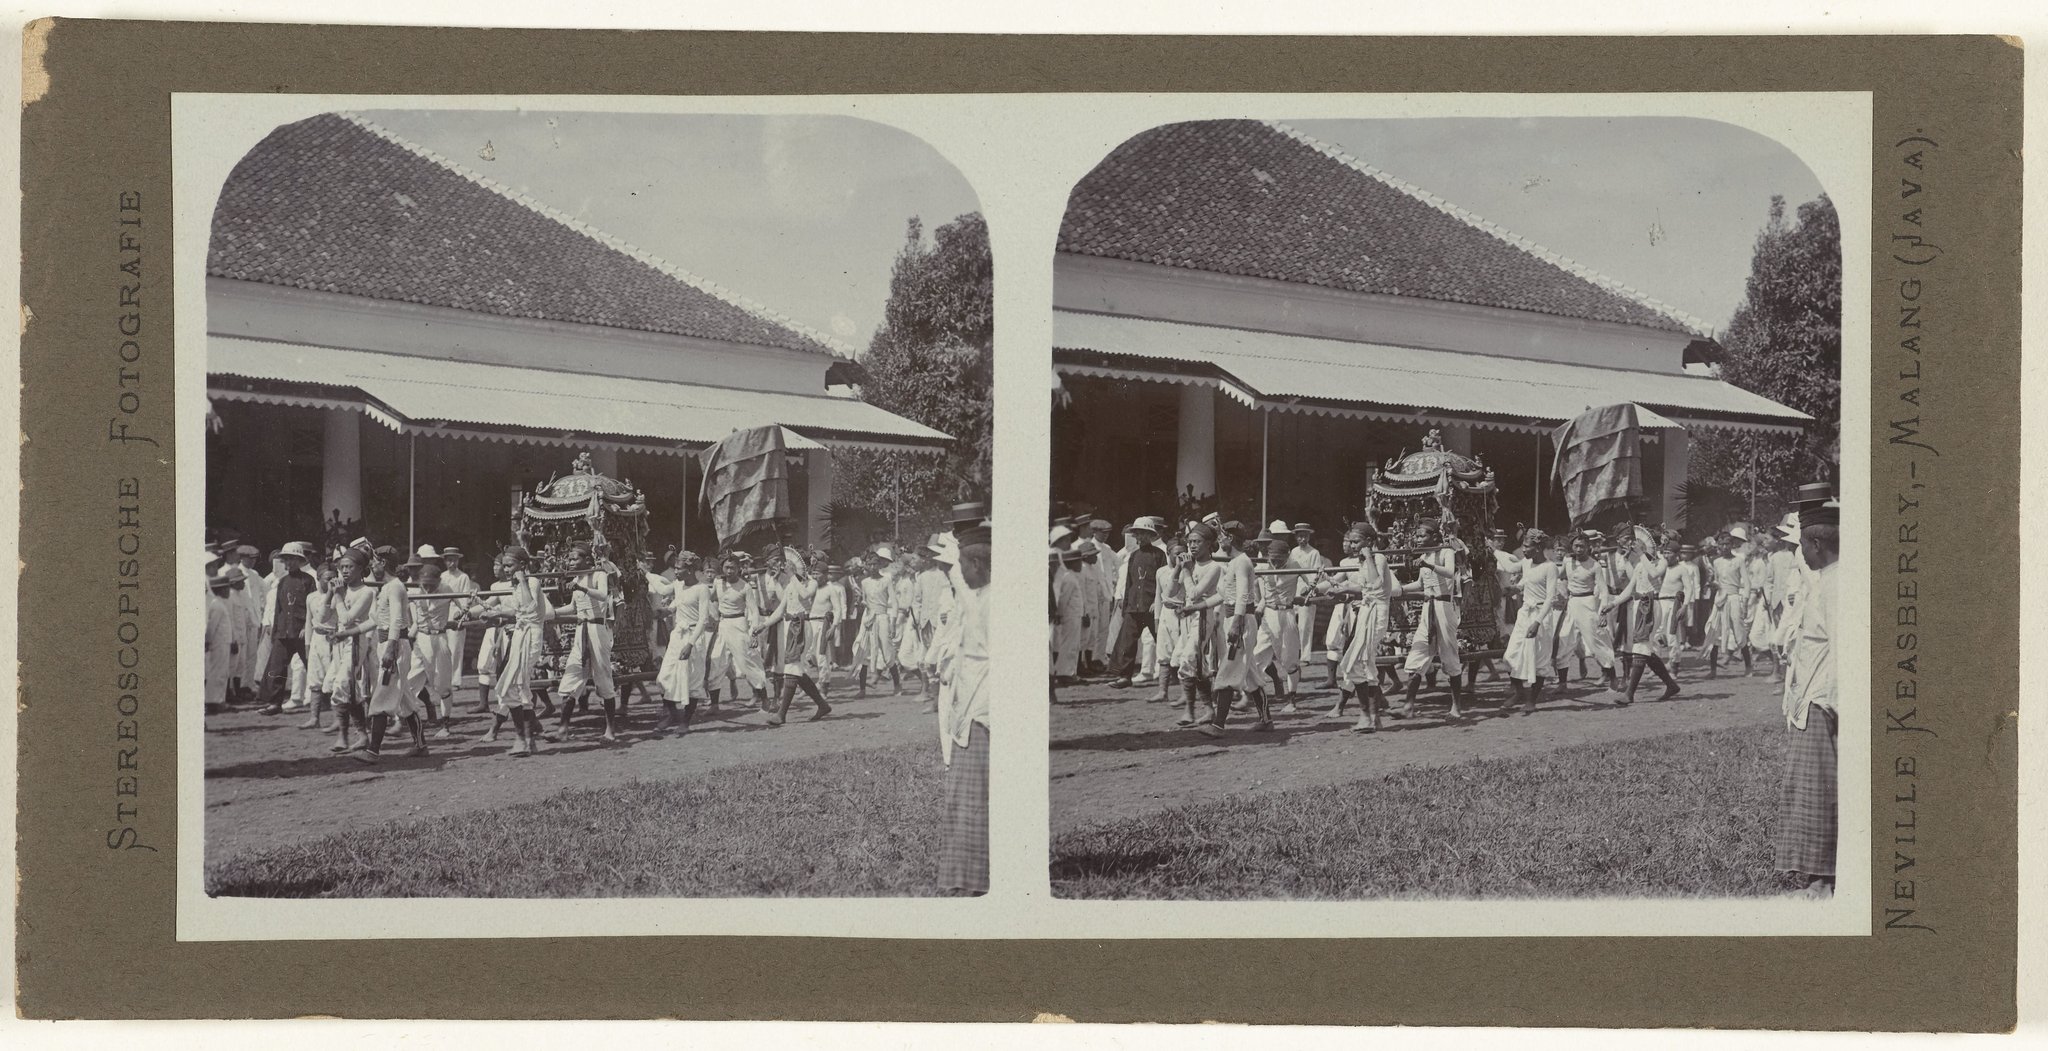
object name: stereograph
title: S 2 No 21. Chin. Godsdienst feest. Tjap Go Meh.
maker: neville keasberry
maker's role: fotograaf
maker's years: 1866-1944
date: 1900-1935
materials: cardboard, paper, photographic support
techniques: albumen print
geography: malang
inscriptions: inscription: ‘Stereoscopische Fotografie’, signature: ‘Neville Keasberry, Malang (Java)’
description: Cap go meh wordt gevierd op de vijftiende dag na nieuwjaar.